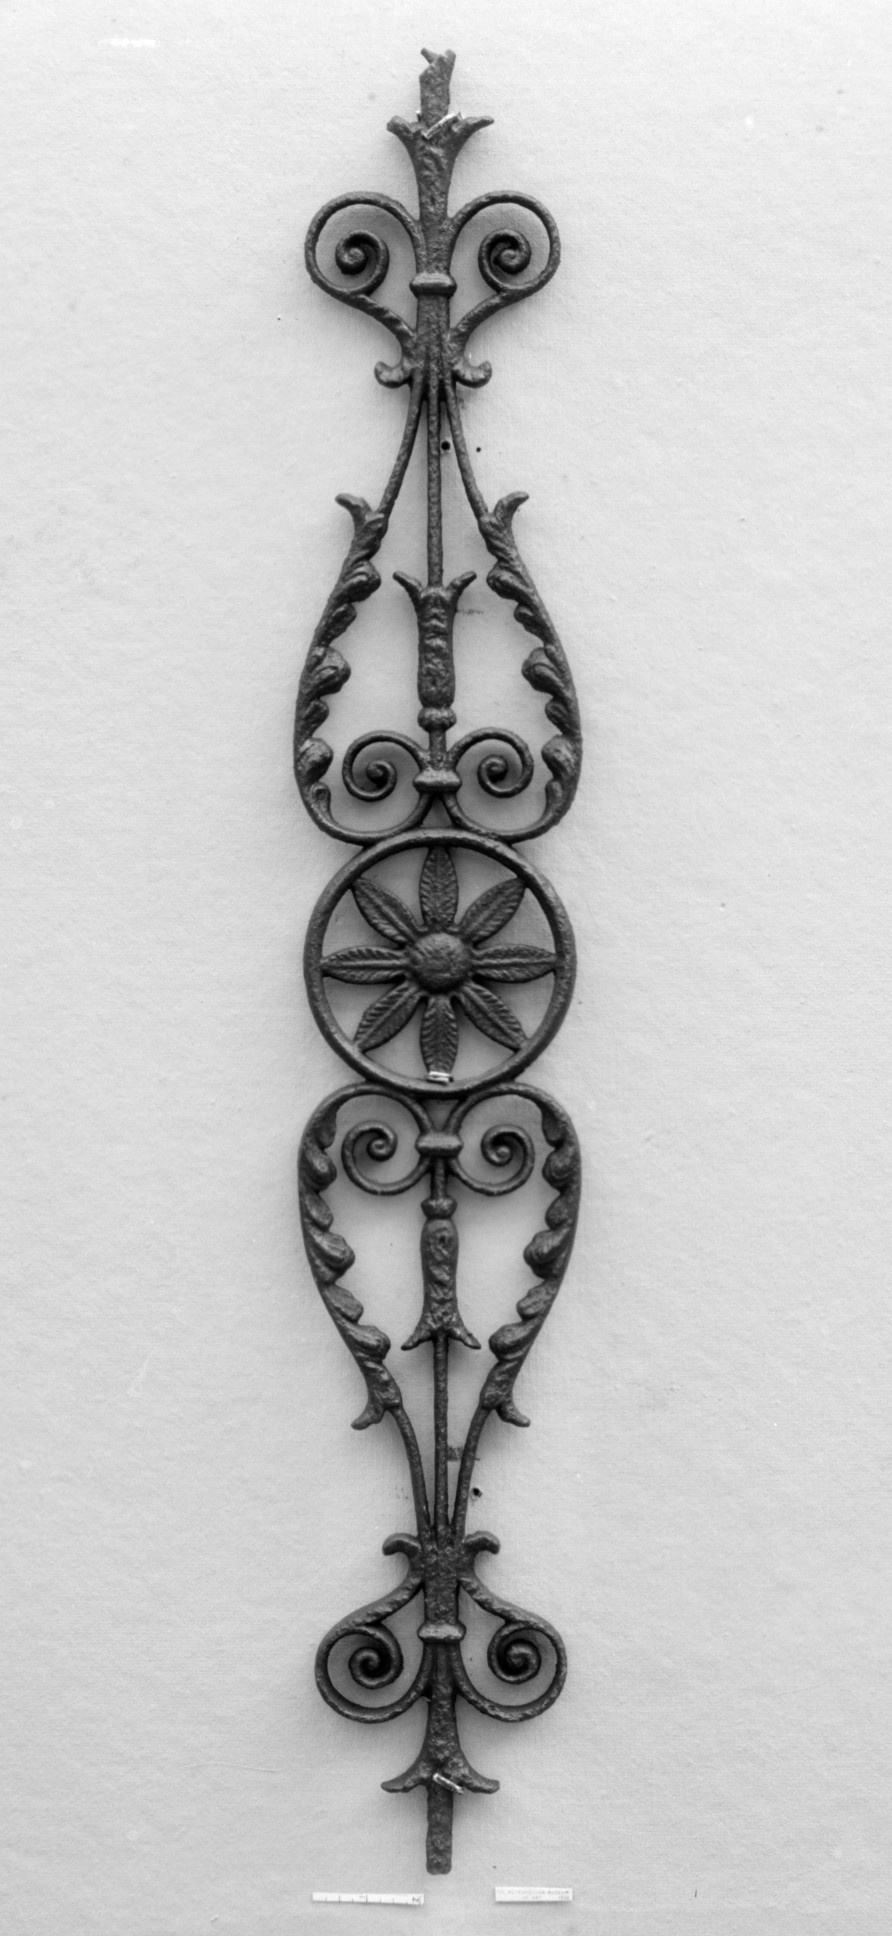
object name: baluster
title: Pair of balusters from a staircase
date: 1801-1825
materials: iron